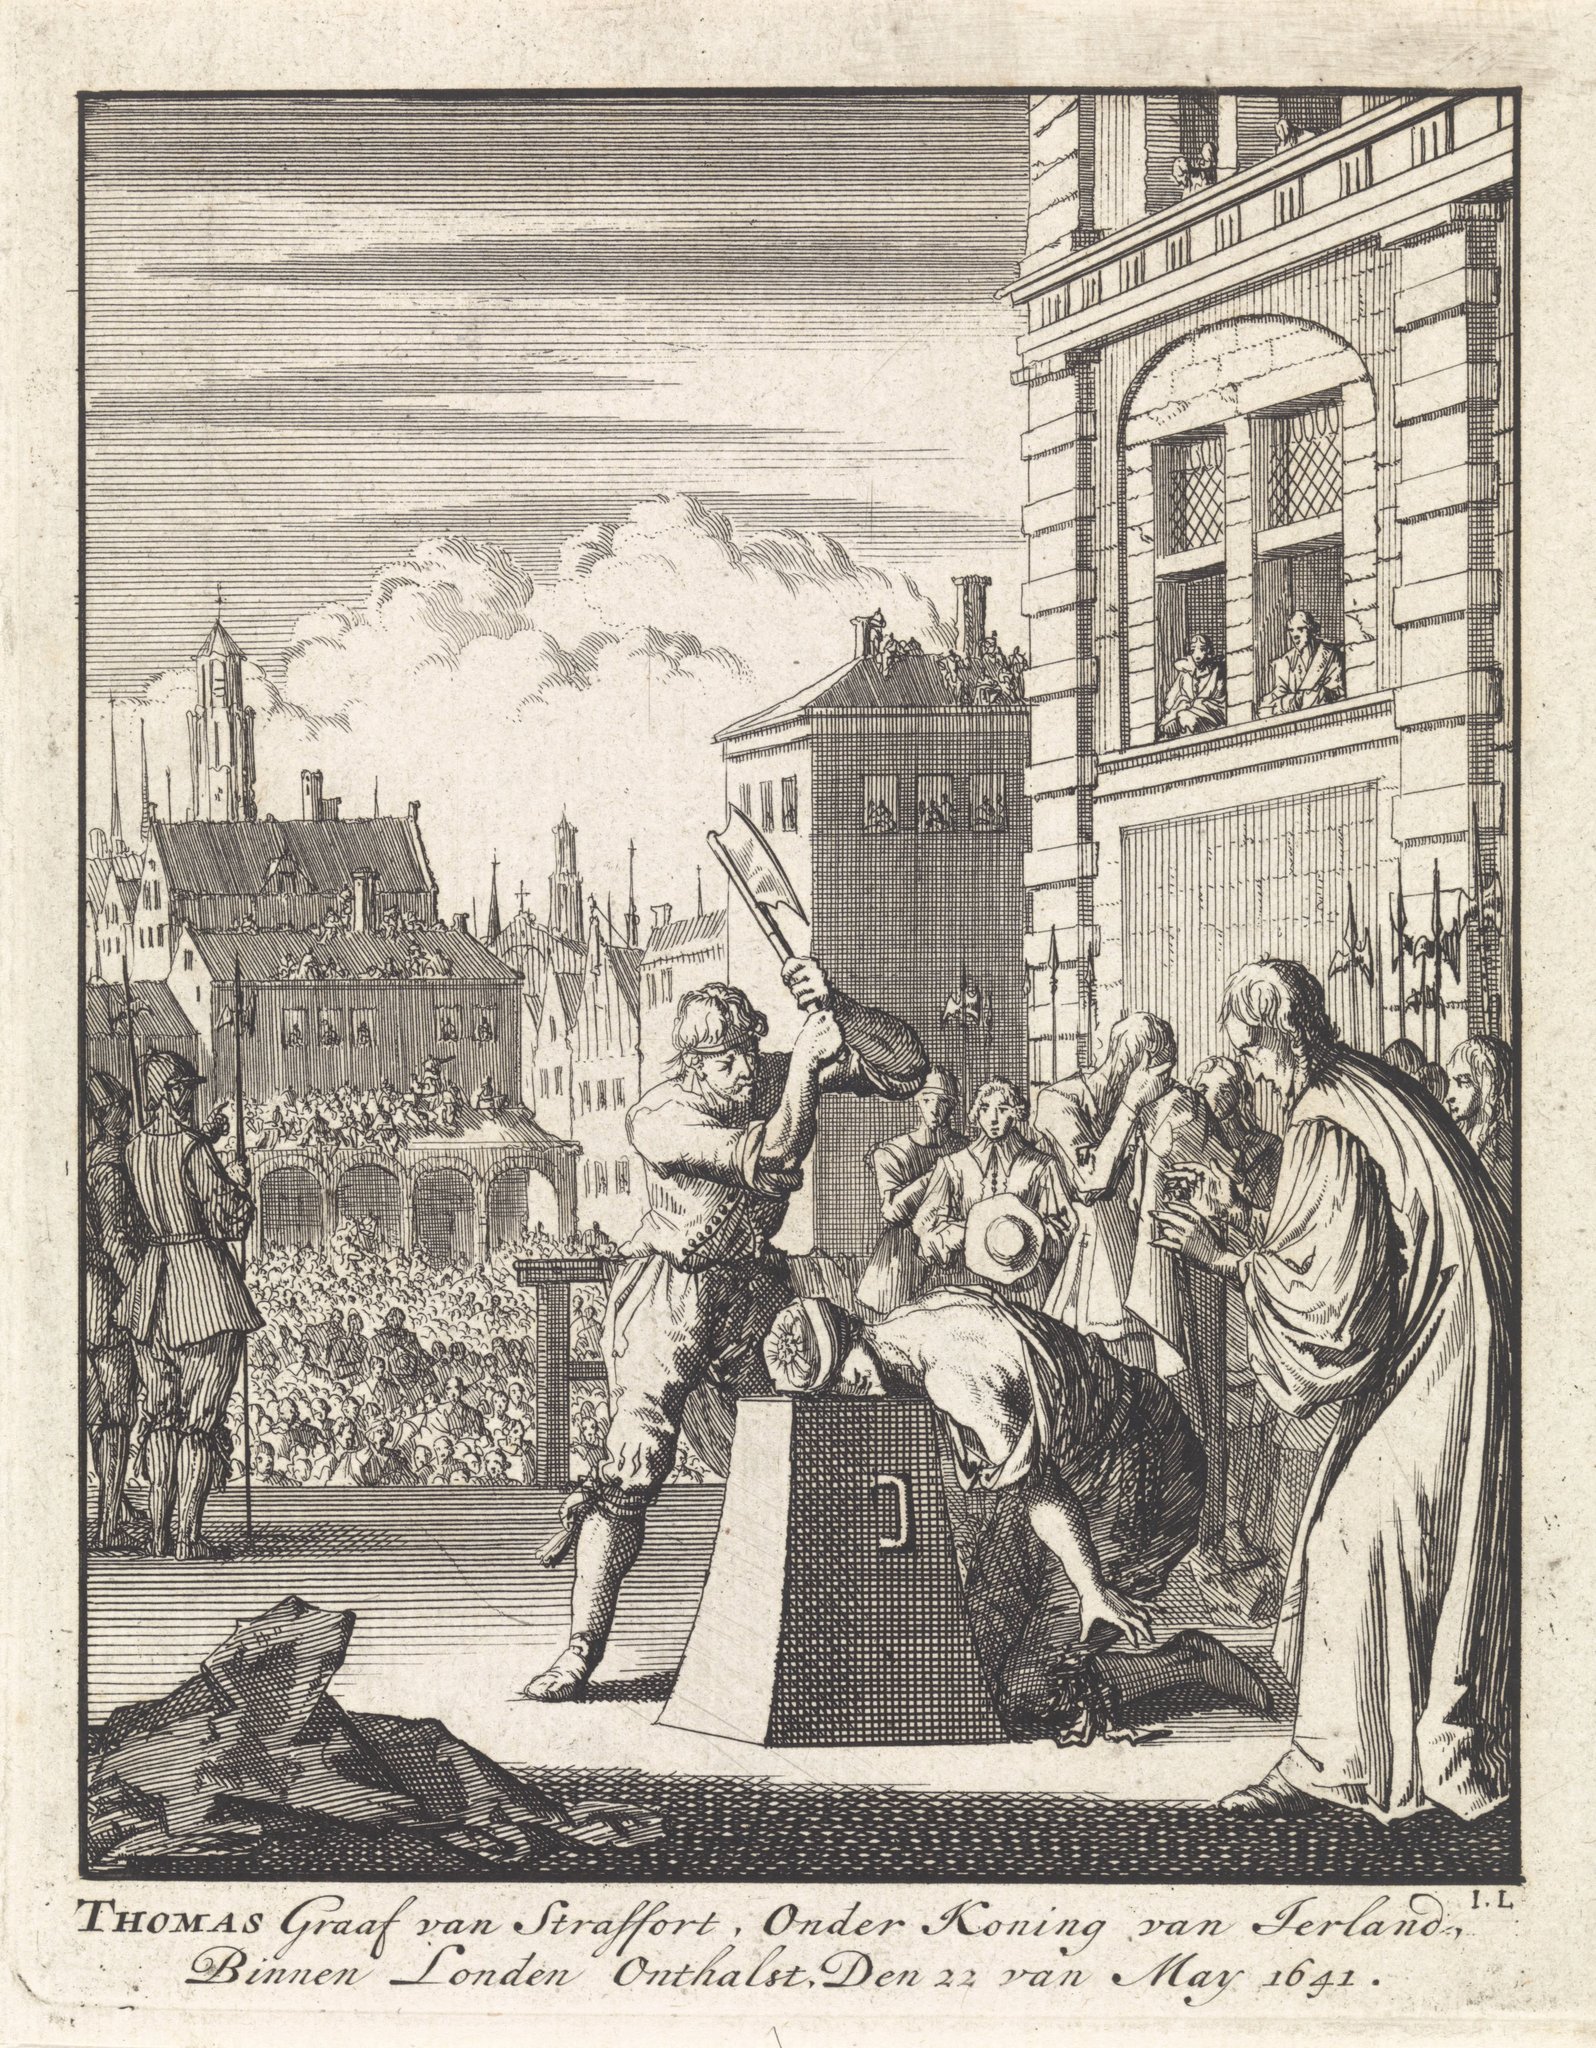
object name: print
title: Thomas Graaf van Staffort, Onder Koning van Ierland, Binnen Londen Onthalst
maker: jan luyken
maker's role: draughtsman, print maker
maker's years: 1649-1712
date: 1698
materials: paper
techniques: etching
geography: amsterdam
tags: london, politician, on the scaffold or place of execution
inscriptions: collector's mark: Lugt 2228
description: Proefdruk van illustratie uit: Bos, Lambert van den. Treur-toonneel der doorluchtige mannen, of Op- en ondergang der grooten, 3 delen. Amsterdam: Jan Claesz ten Hoorn, 1698, dl. II.